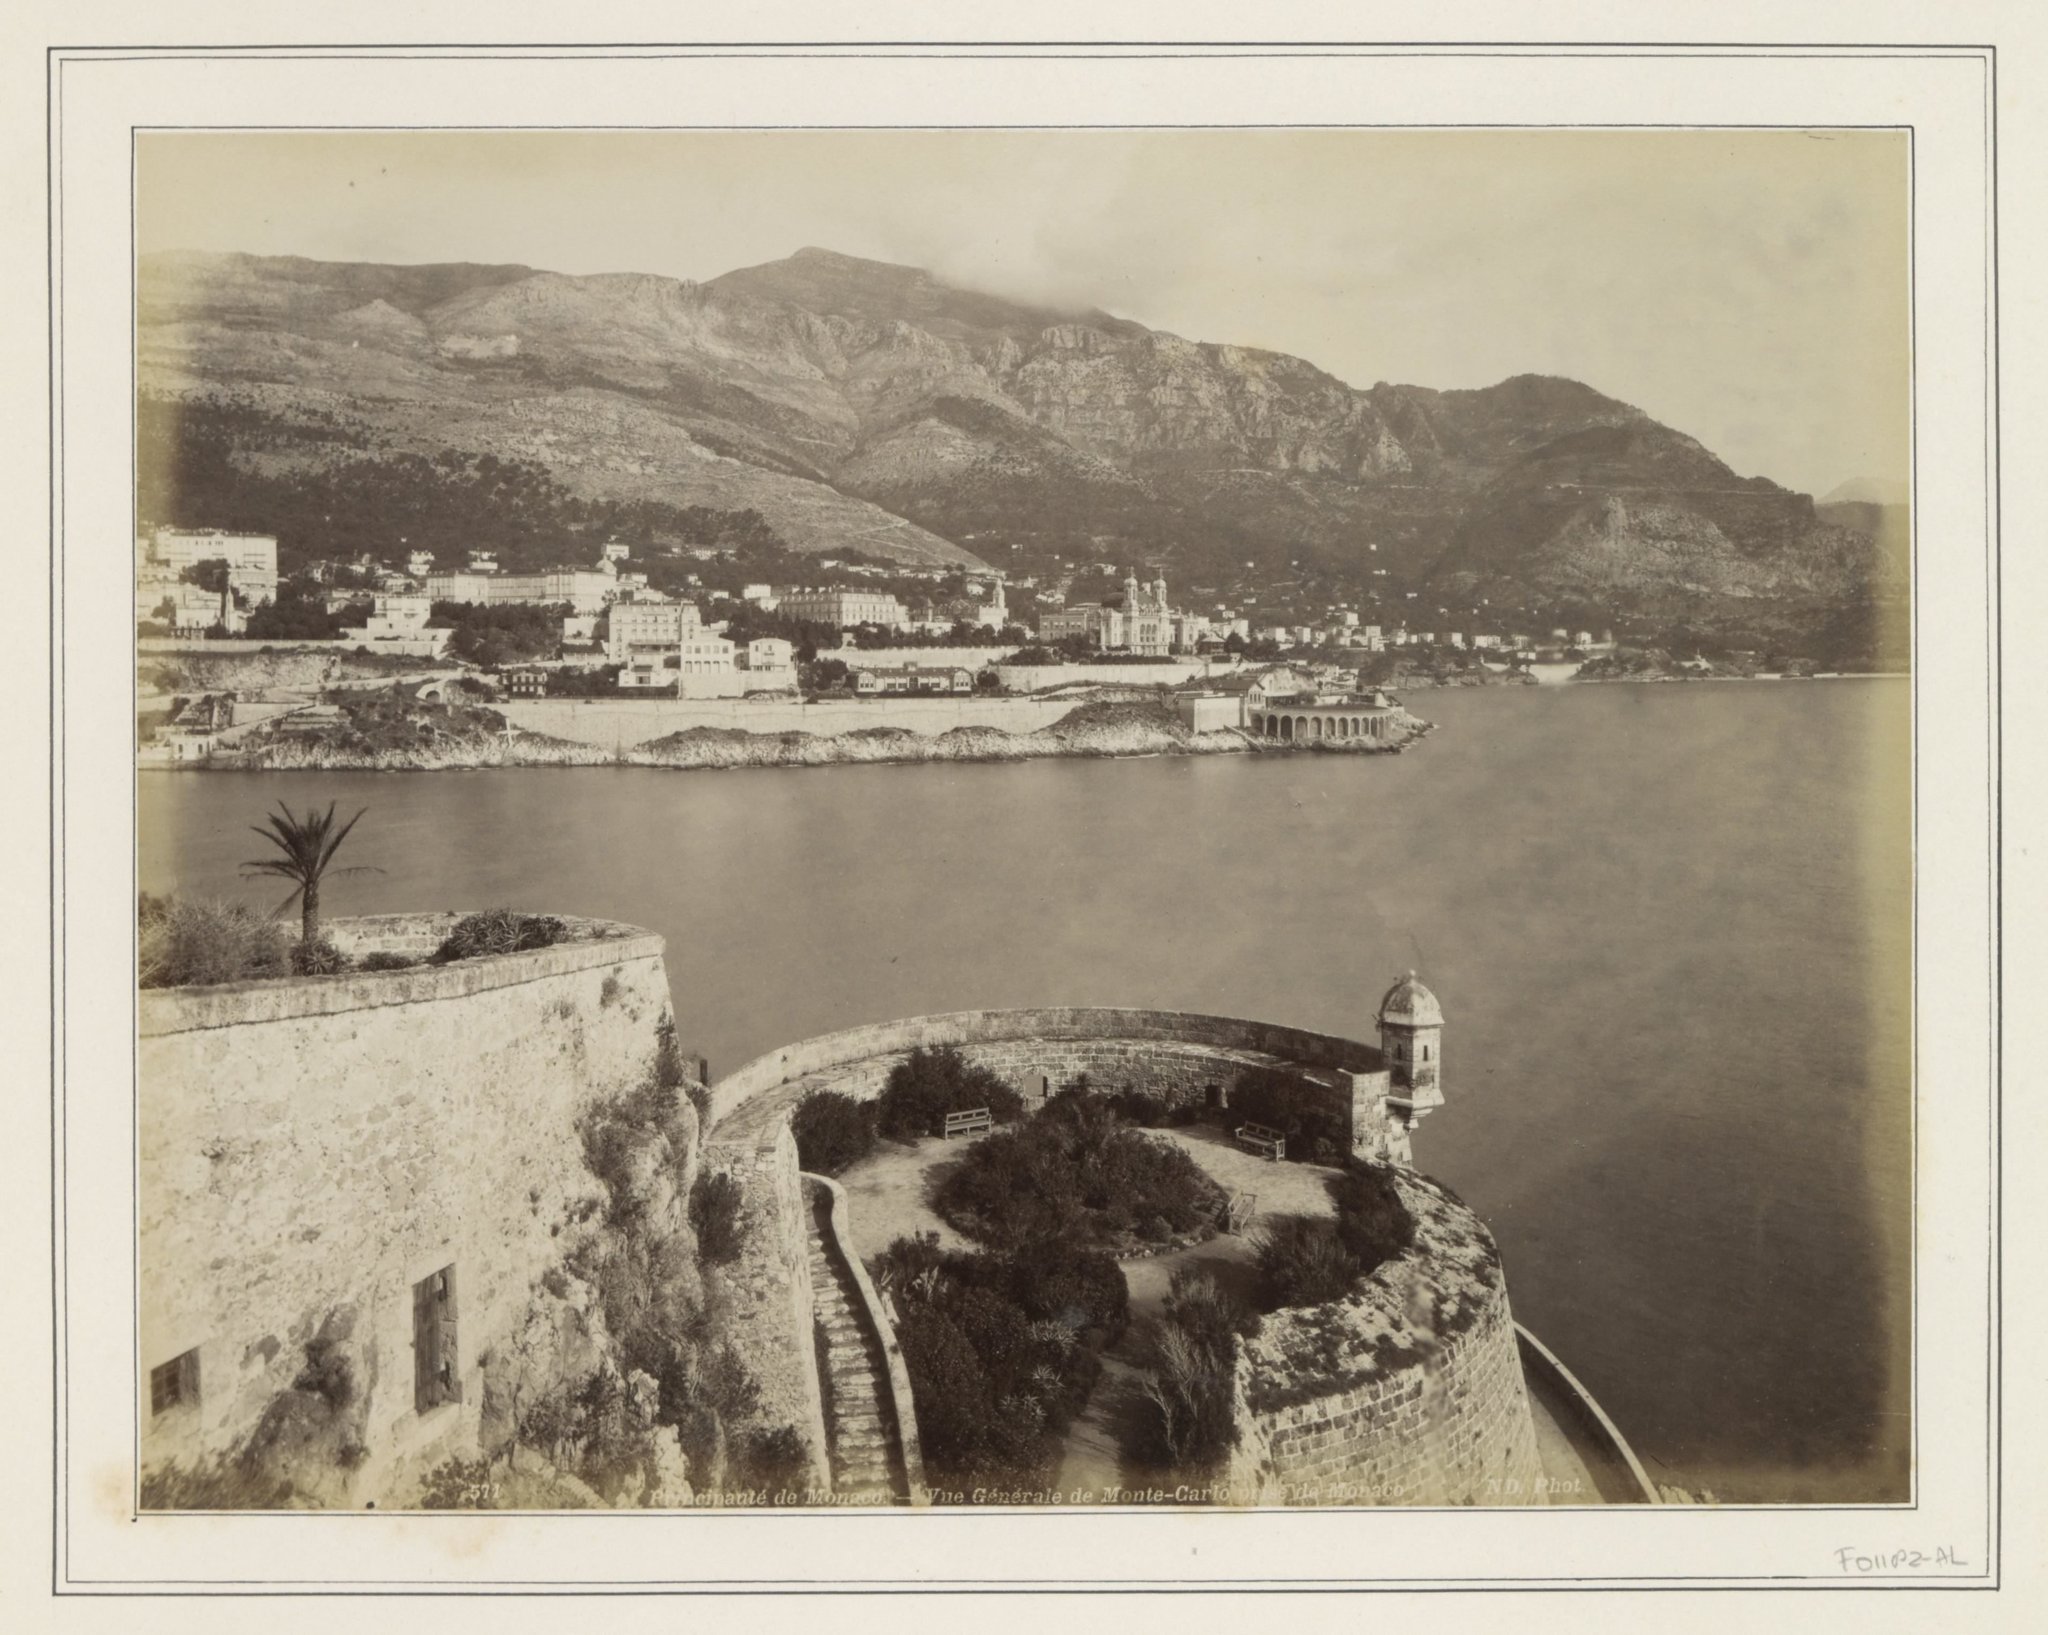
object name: photograph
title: Principauté de Monaco - Vue Générale de Monte-Carlo prise de Monaco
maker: étienne neurdein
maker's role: publisher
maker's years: 1832-1918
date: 1860-1890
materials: paper, photographic support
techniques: albumen print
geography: monaco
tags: prospect of village, silhouette of village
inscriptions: negative number: ‘571’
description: Onderdeel van Reisalbum met foto's van bezienswaardigheden in Italië en aan de Franse Rivièra (deel II).